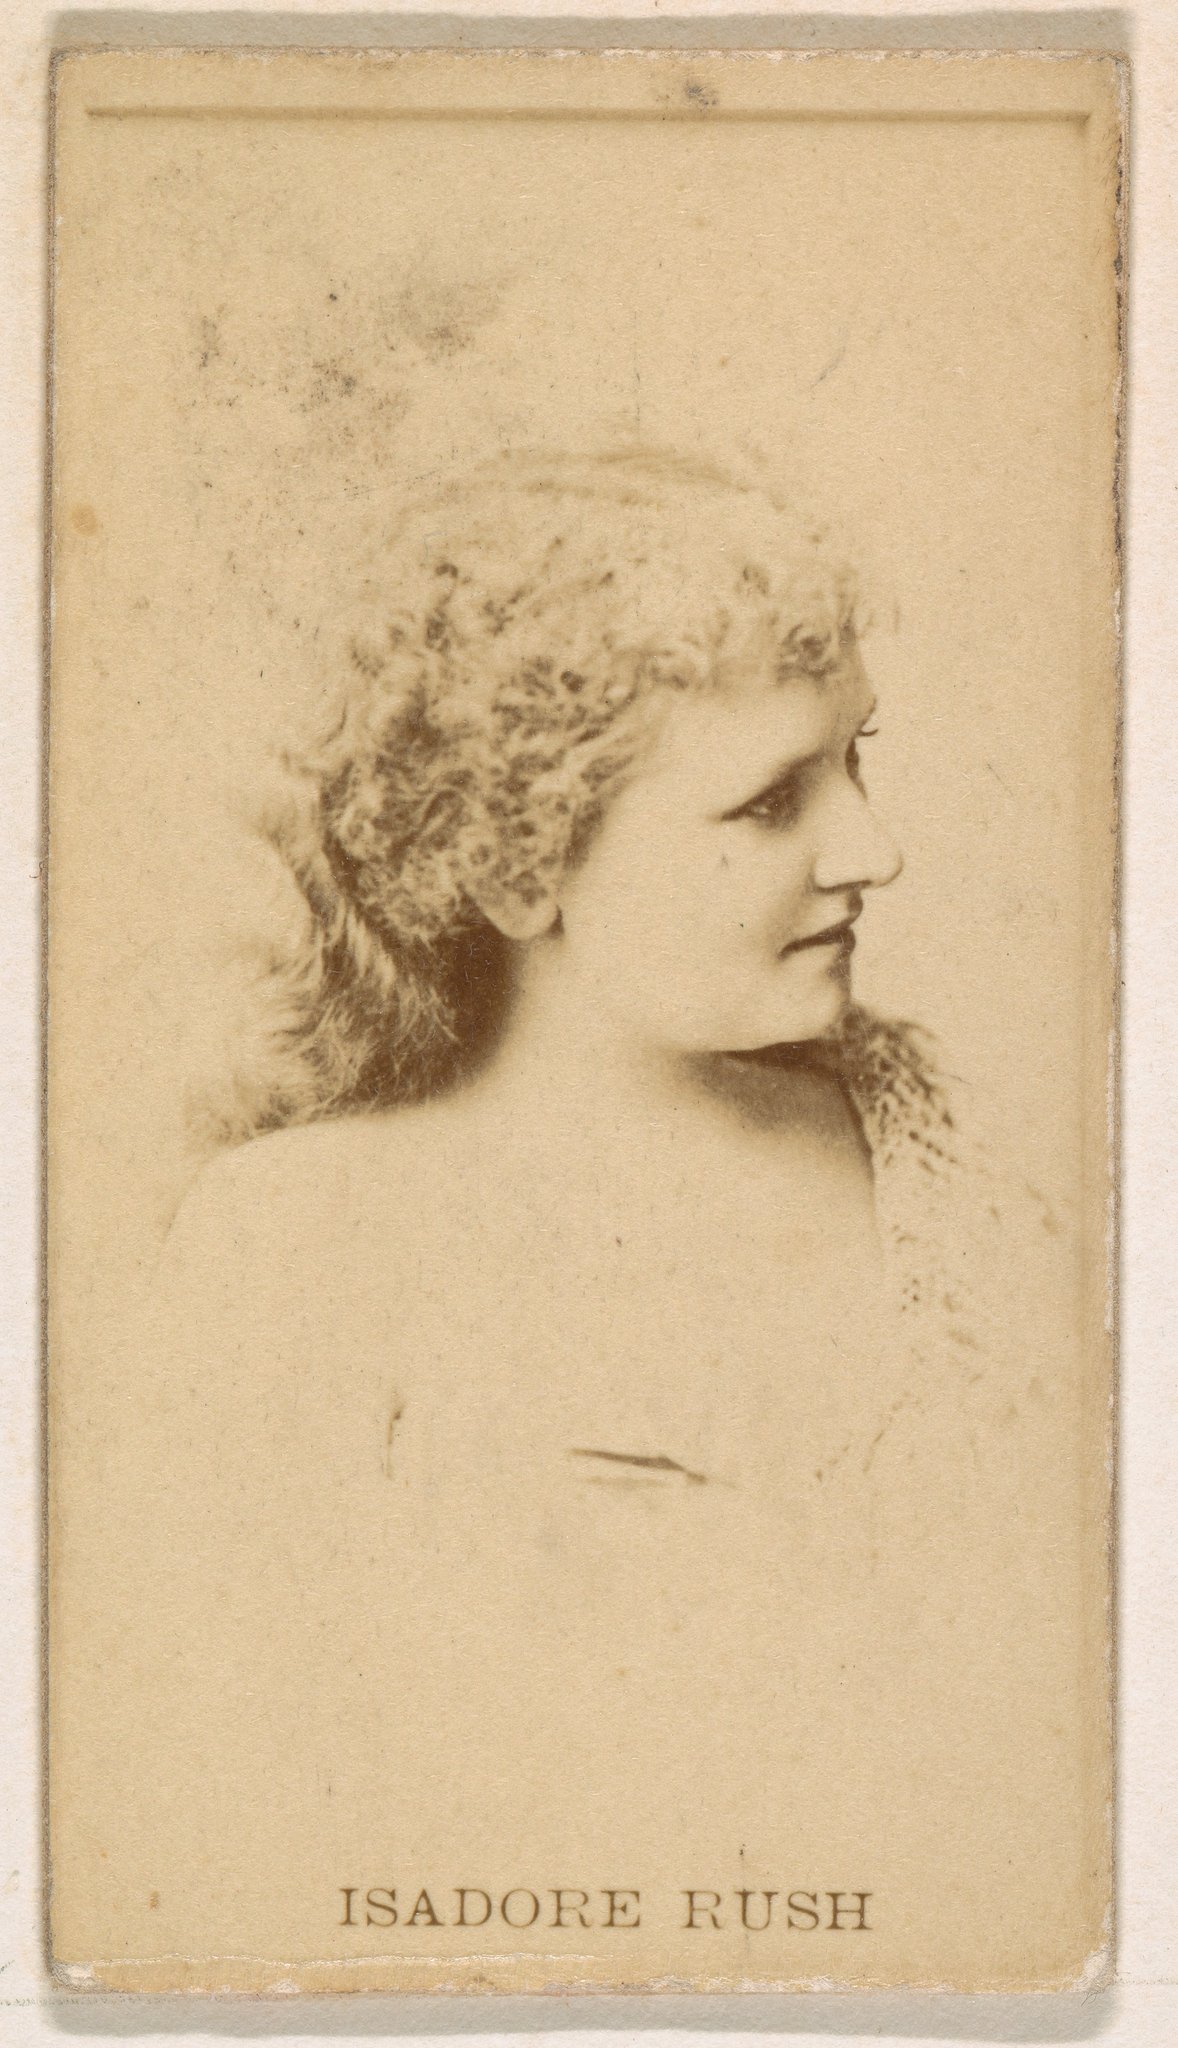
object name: photograph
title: Isadore Rush, from the Actresses series (N245) issued by Kinney Brothers to promote Sweet Caporal Cigarettes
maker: kinney brothers tobacco company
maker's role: publisher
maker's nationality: american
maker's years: 1869-2011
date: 1890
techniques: albumen silver print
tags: portraits,women,actresses